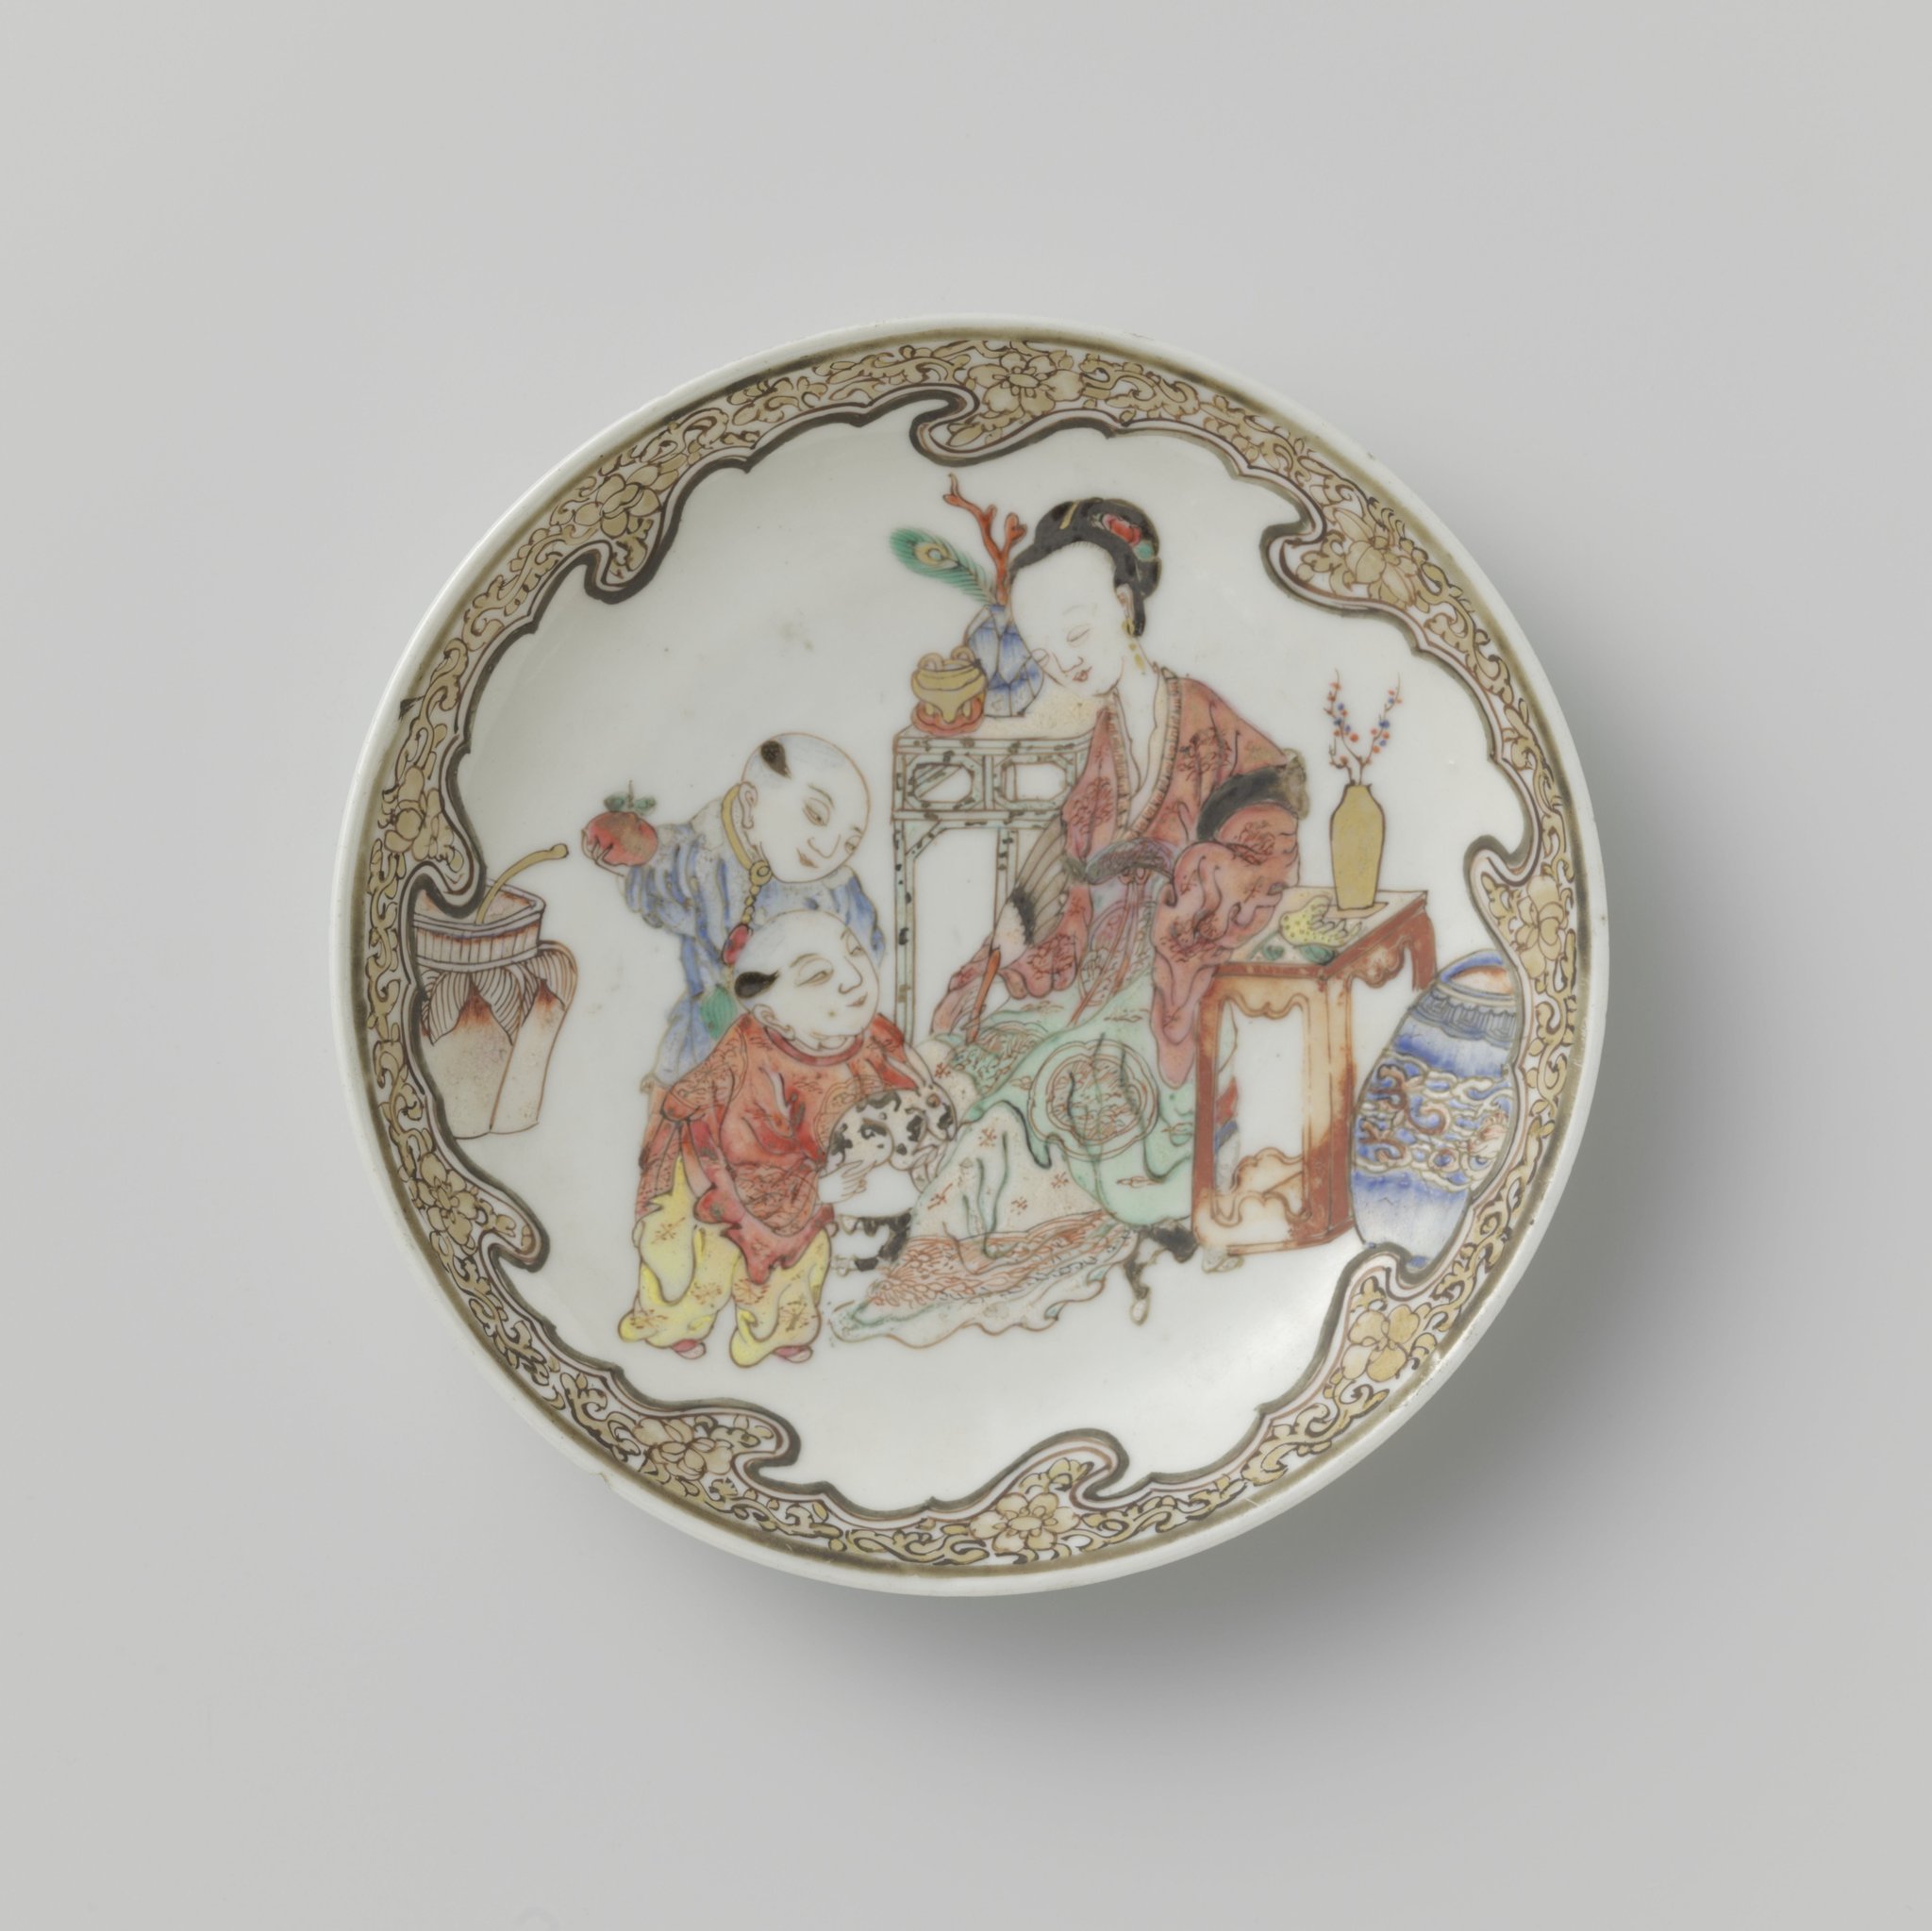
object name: platter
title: Saucer with a seated woman and two boys amid antiquities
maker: Anonymous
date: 1725-1749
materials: glaze, gold, paint, porcelain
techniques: firing, gilding, turning, vitrification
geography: china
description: Schotel van porselein, beschilderd op het glazuur in blauw, rood, roze, groen, geel, zwart en goud. Op het plat een cartouche met een zittende vrouw en twee jongens, één met een perzik en één met een haas, tussen antiquiteiten en gelukssymbolen (vaas met pauwenveer en koraal, wierookbrander, vingercitroen); om het cartouche bloemranken. Een chip in de rand. Famille rose.